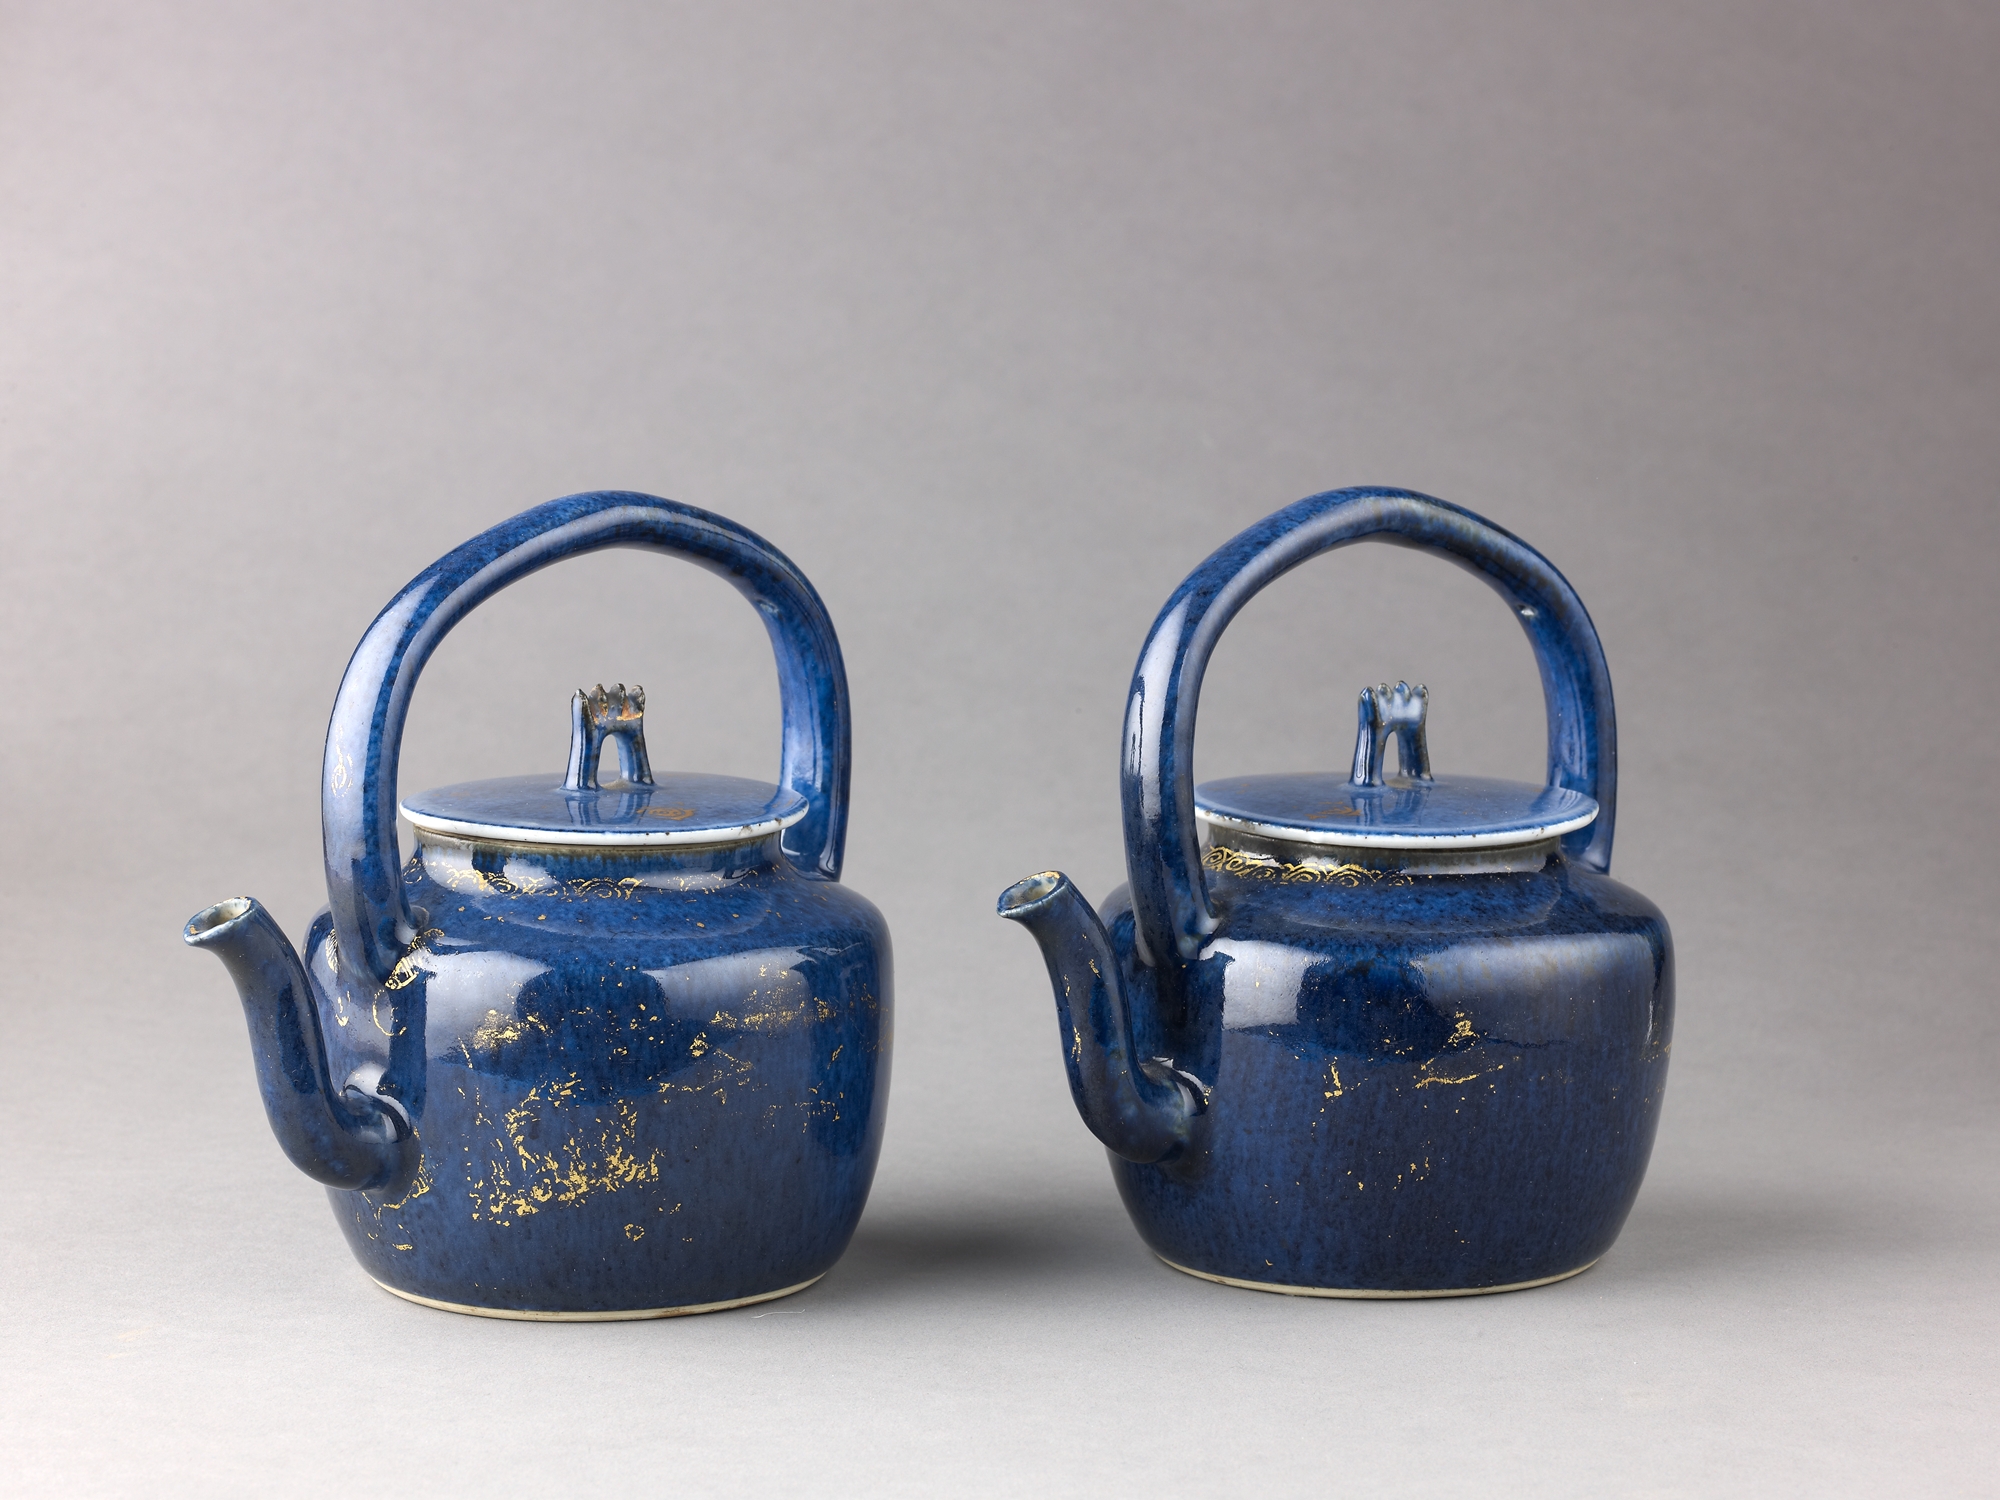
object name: covered winepot or teapot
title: Covered teapot or wine pot (pair with 1975.1.1704)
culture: chinese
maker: chinese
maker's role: artist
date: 1662-1722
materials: gilt, glaze, porcelain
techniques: overglaze, painting